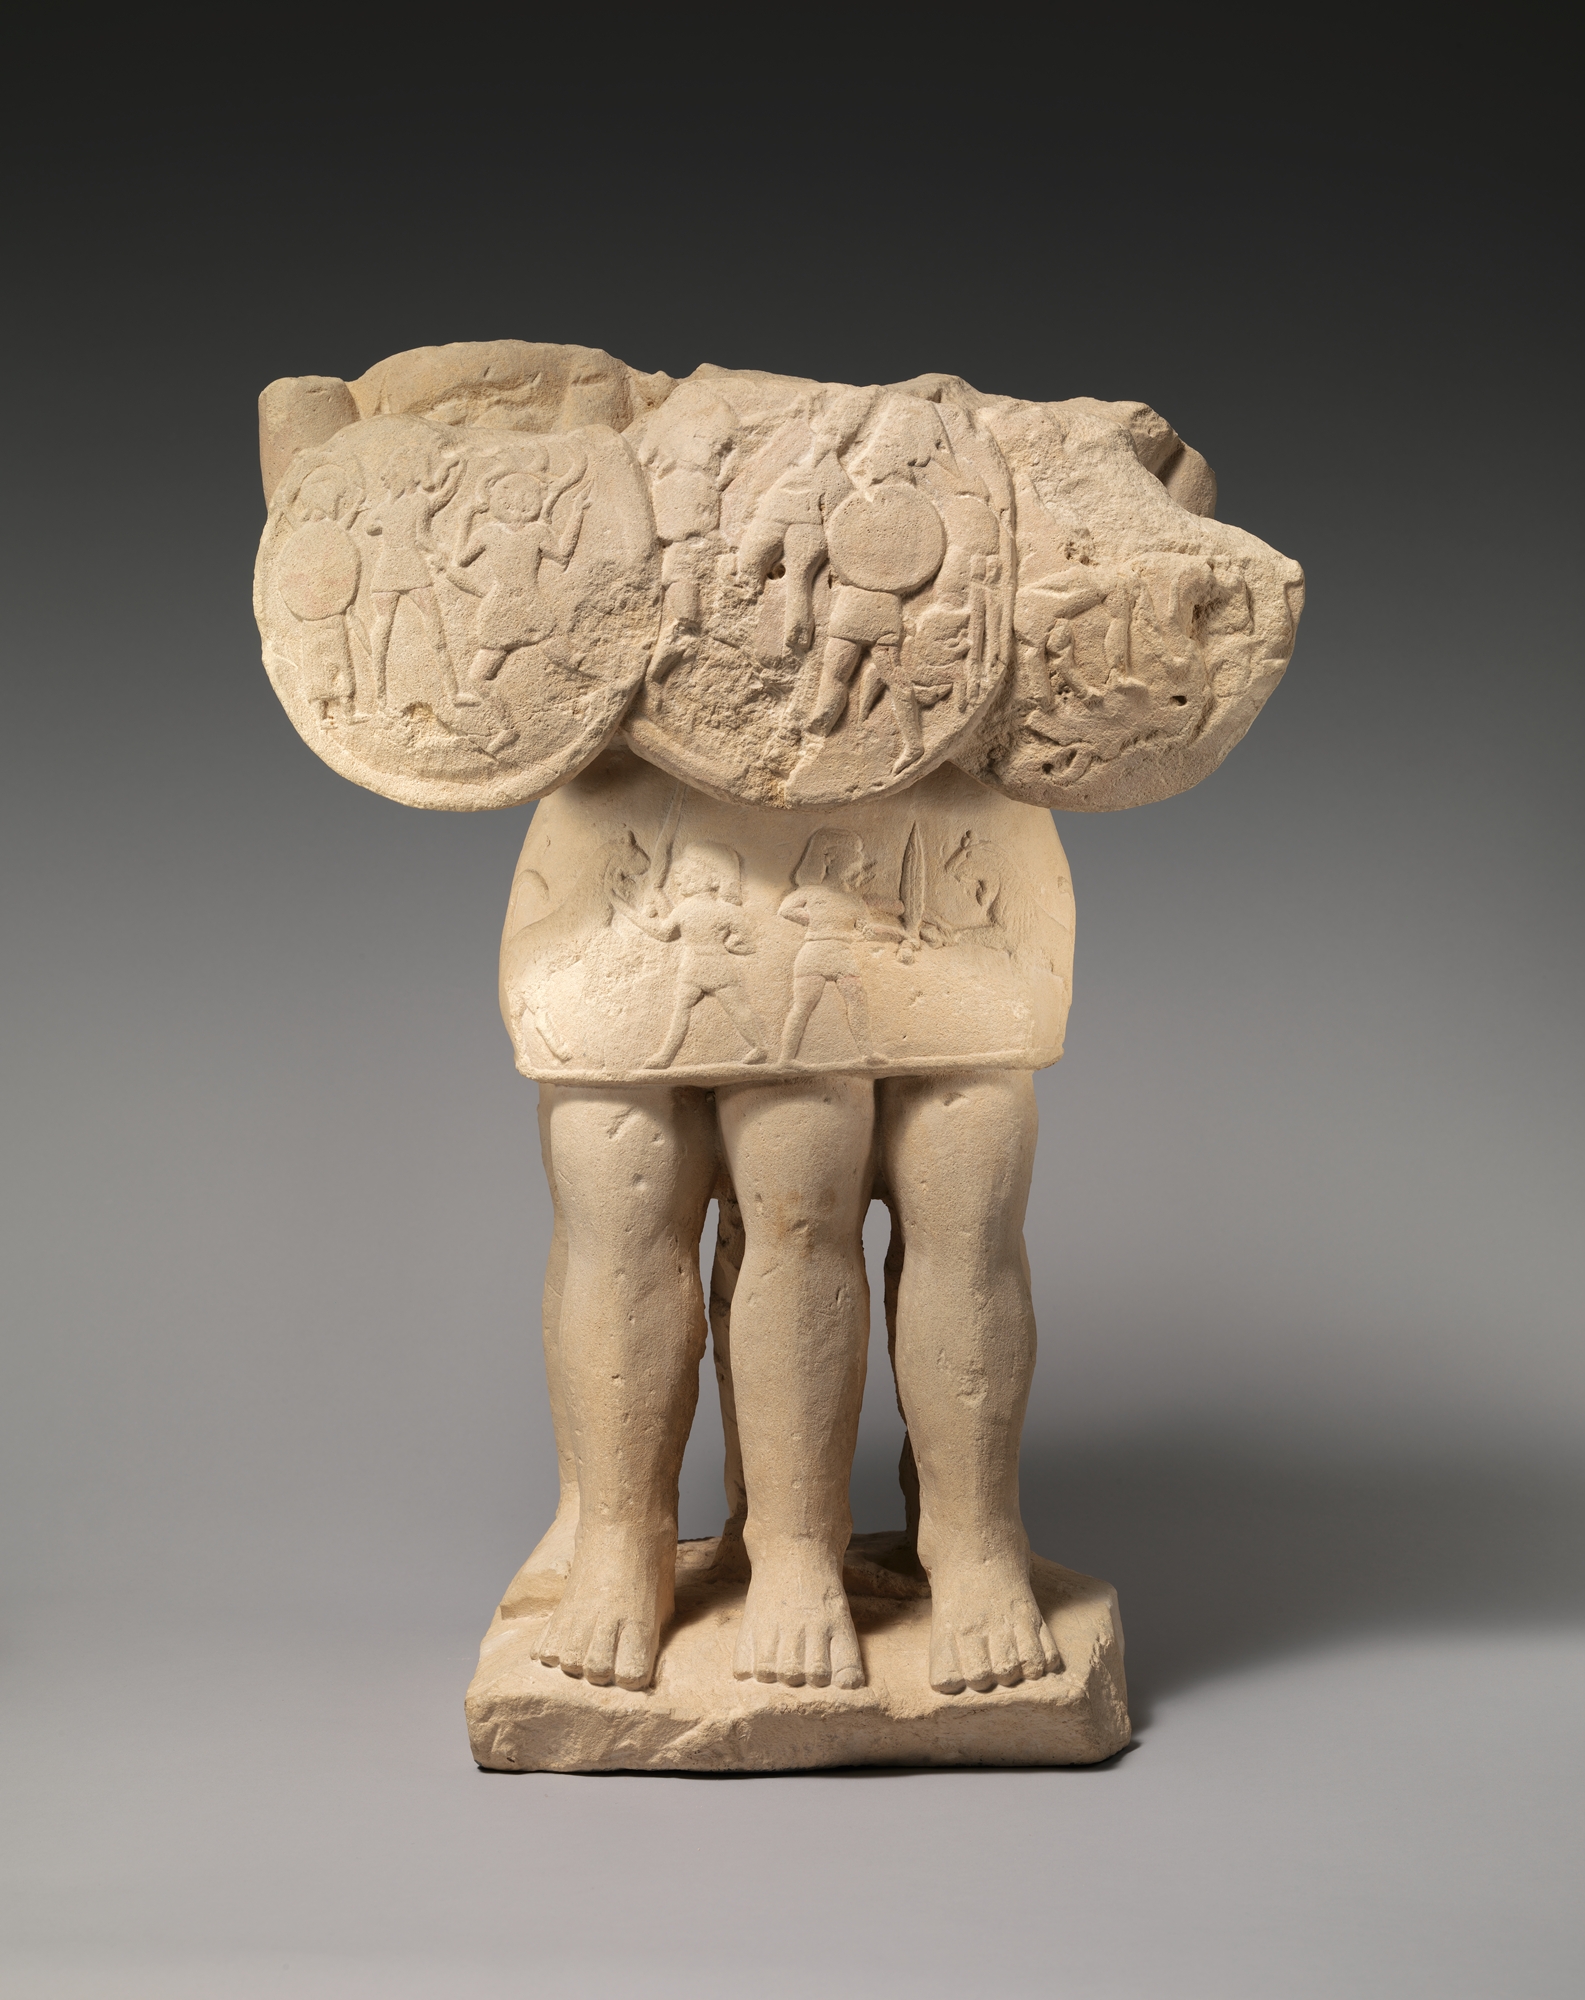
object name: statue of geryon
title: Limestone Geryon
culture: cypriot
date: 550-501 BCE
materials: limestone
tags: shields,perseus,lions,gorgons